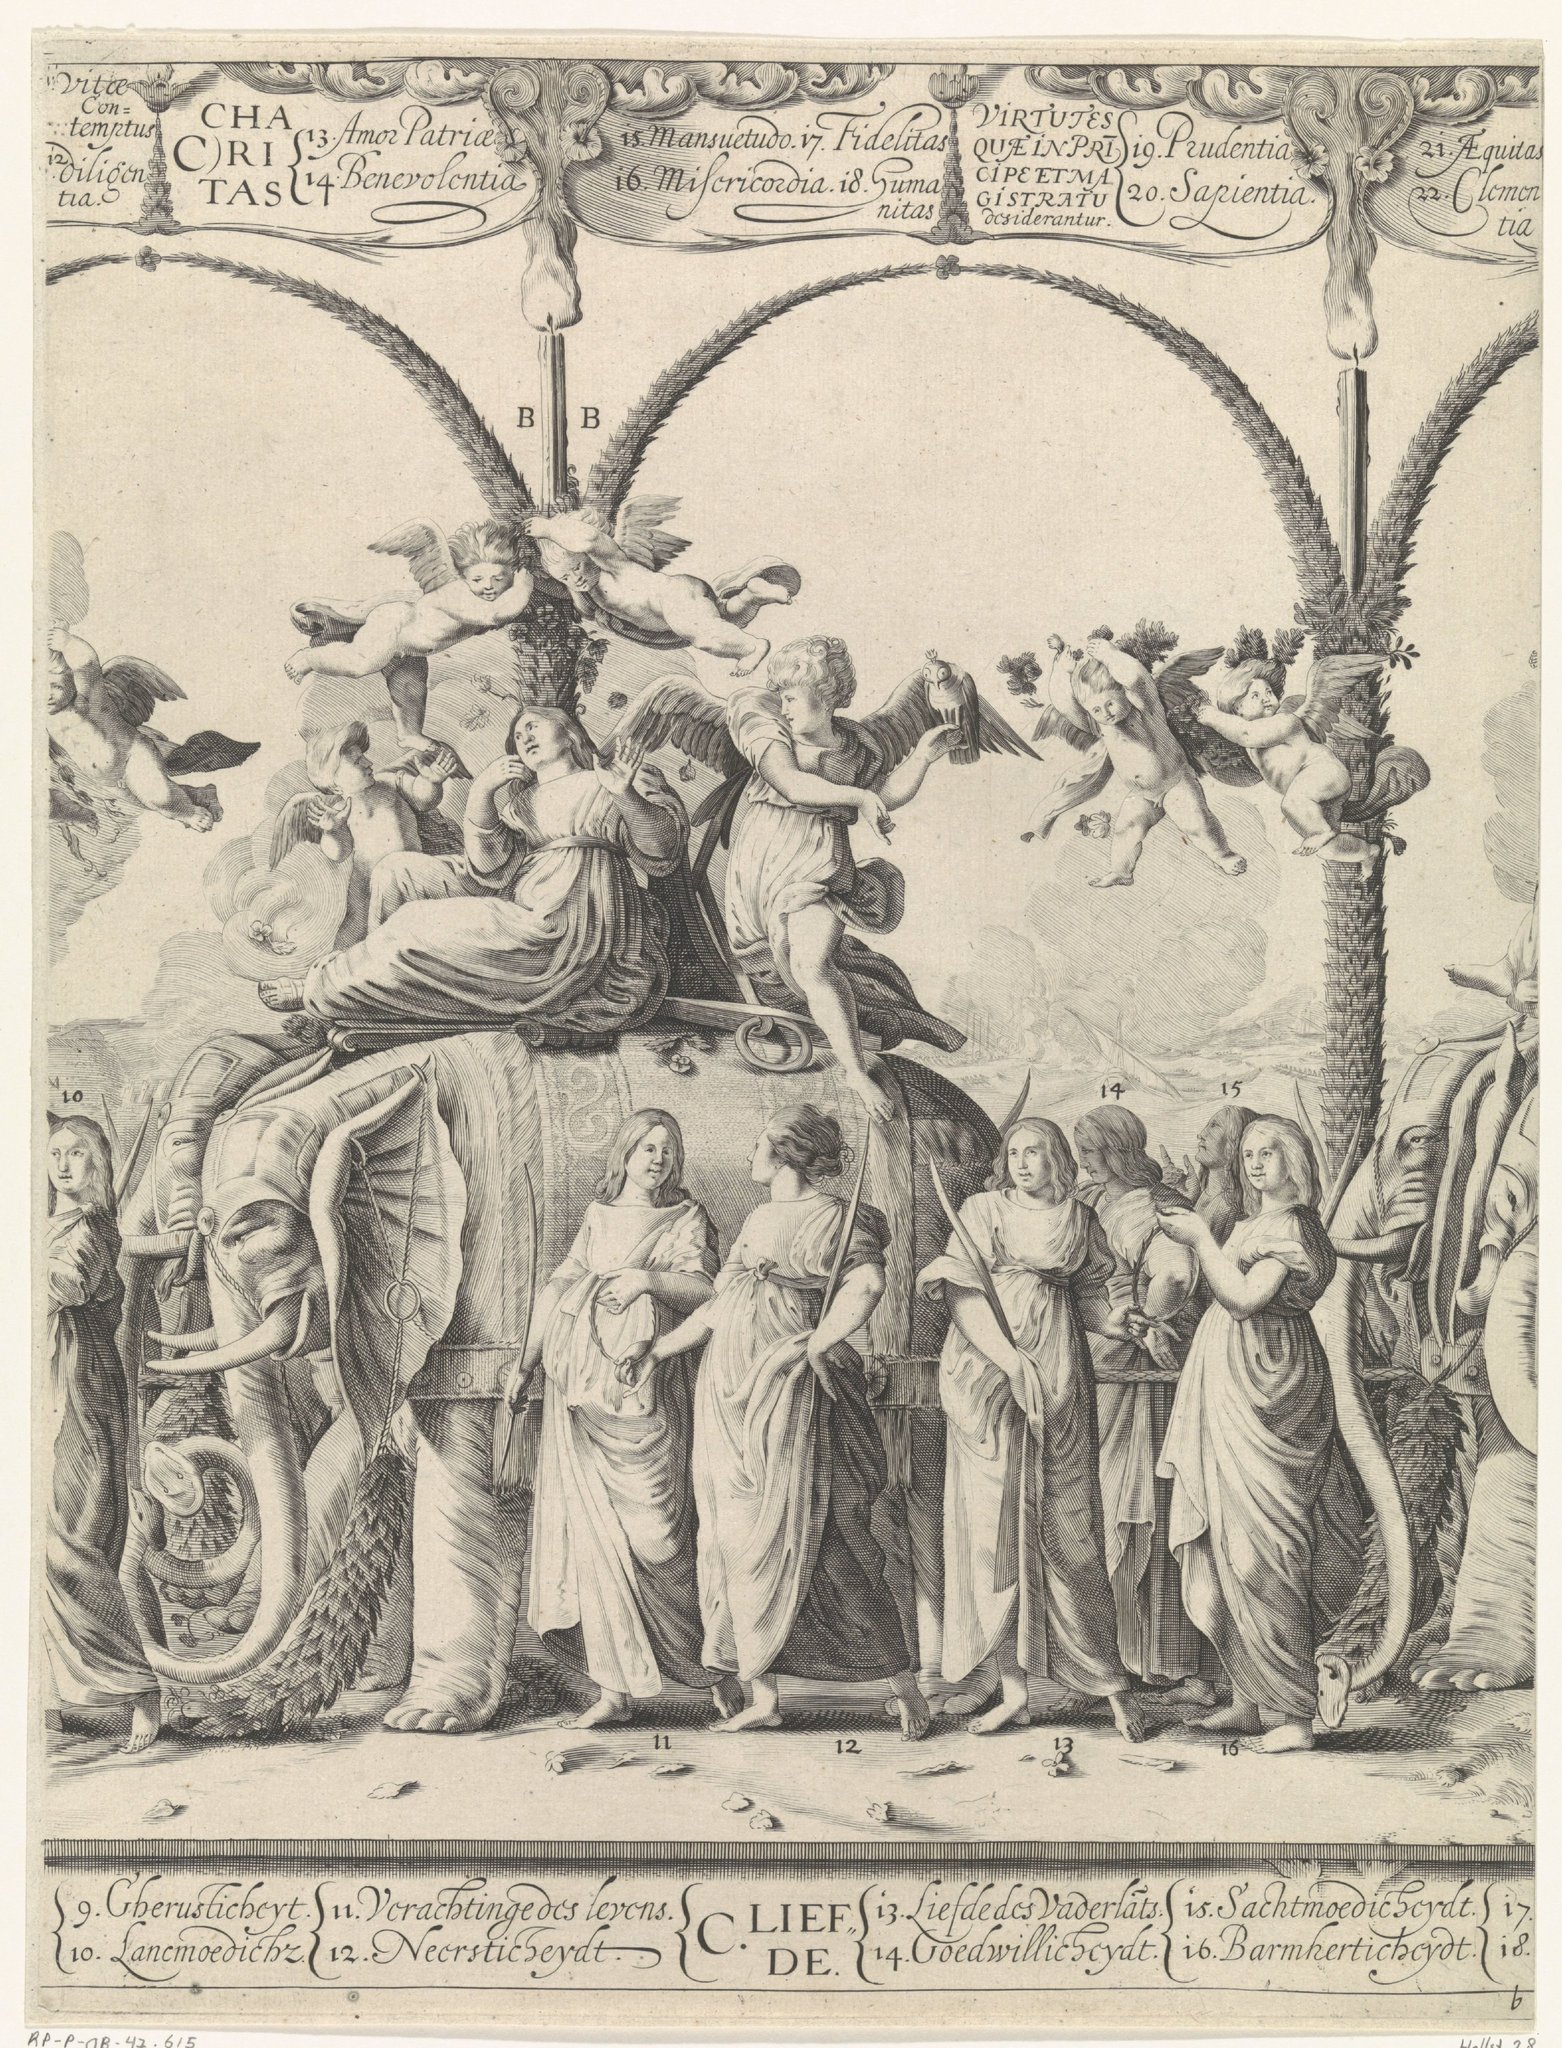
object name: propagandaprent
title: Triomftocht van Willem van Oranje, linksmidden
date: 1623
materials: paper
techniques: engraving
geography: haarlem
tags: delft, william i (prince of orange), trunked animals, hope, 'spes'; 'speranza divina e certa' (ripa) ~ one of the three theological virtues, symbolic triumphs of individual persons, cupids: 'amores', 'amoretti', 'putti'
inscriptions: collector's mark: Lugt 2228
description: Plaat linksmidden van vijf platen van 'Triomftocht van Willem van Oranje' met zinnebeeldige voorstellingen van de deugden van Prins Willem van Oranje, bestaande uit: de Christelijke Deugden, de overheidsdeugden en de krijgsdeugden. In deze prent staan de Christelijke Deugden centraal. In het midden (onder de B) een olifant met op zijn rug de personificatie van Hoop, een van de Christelijke Deugden. Om de olifant heen vliegen putti en lopen andere personificaties van deugden die met het geloof verbonden zijn, zoals Lijdzaamheid (7) en Zachtmoedigheid (10). De personificaties zijn voorzien van een nummer, waarvan de verklaring in het Latijn boven de afbeelding en in het Nederlands onder de afbeelding staat.